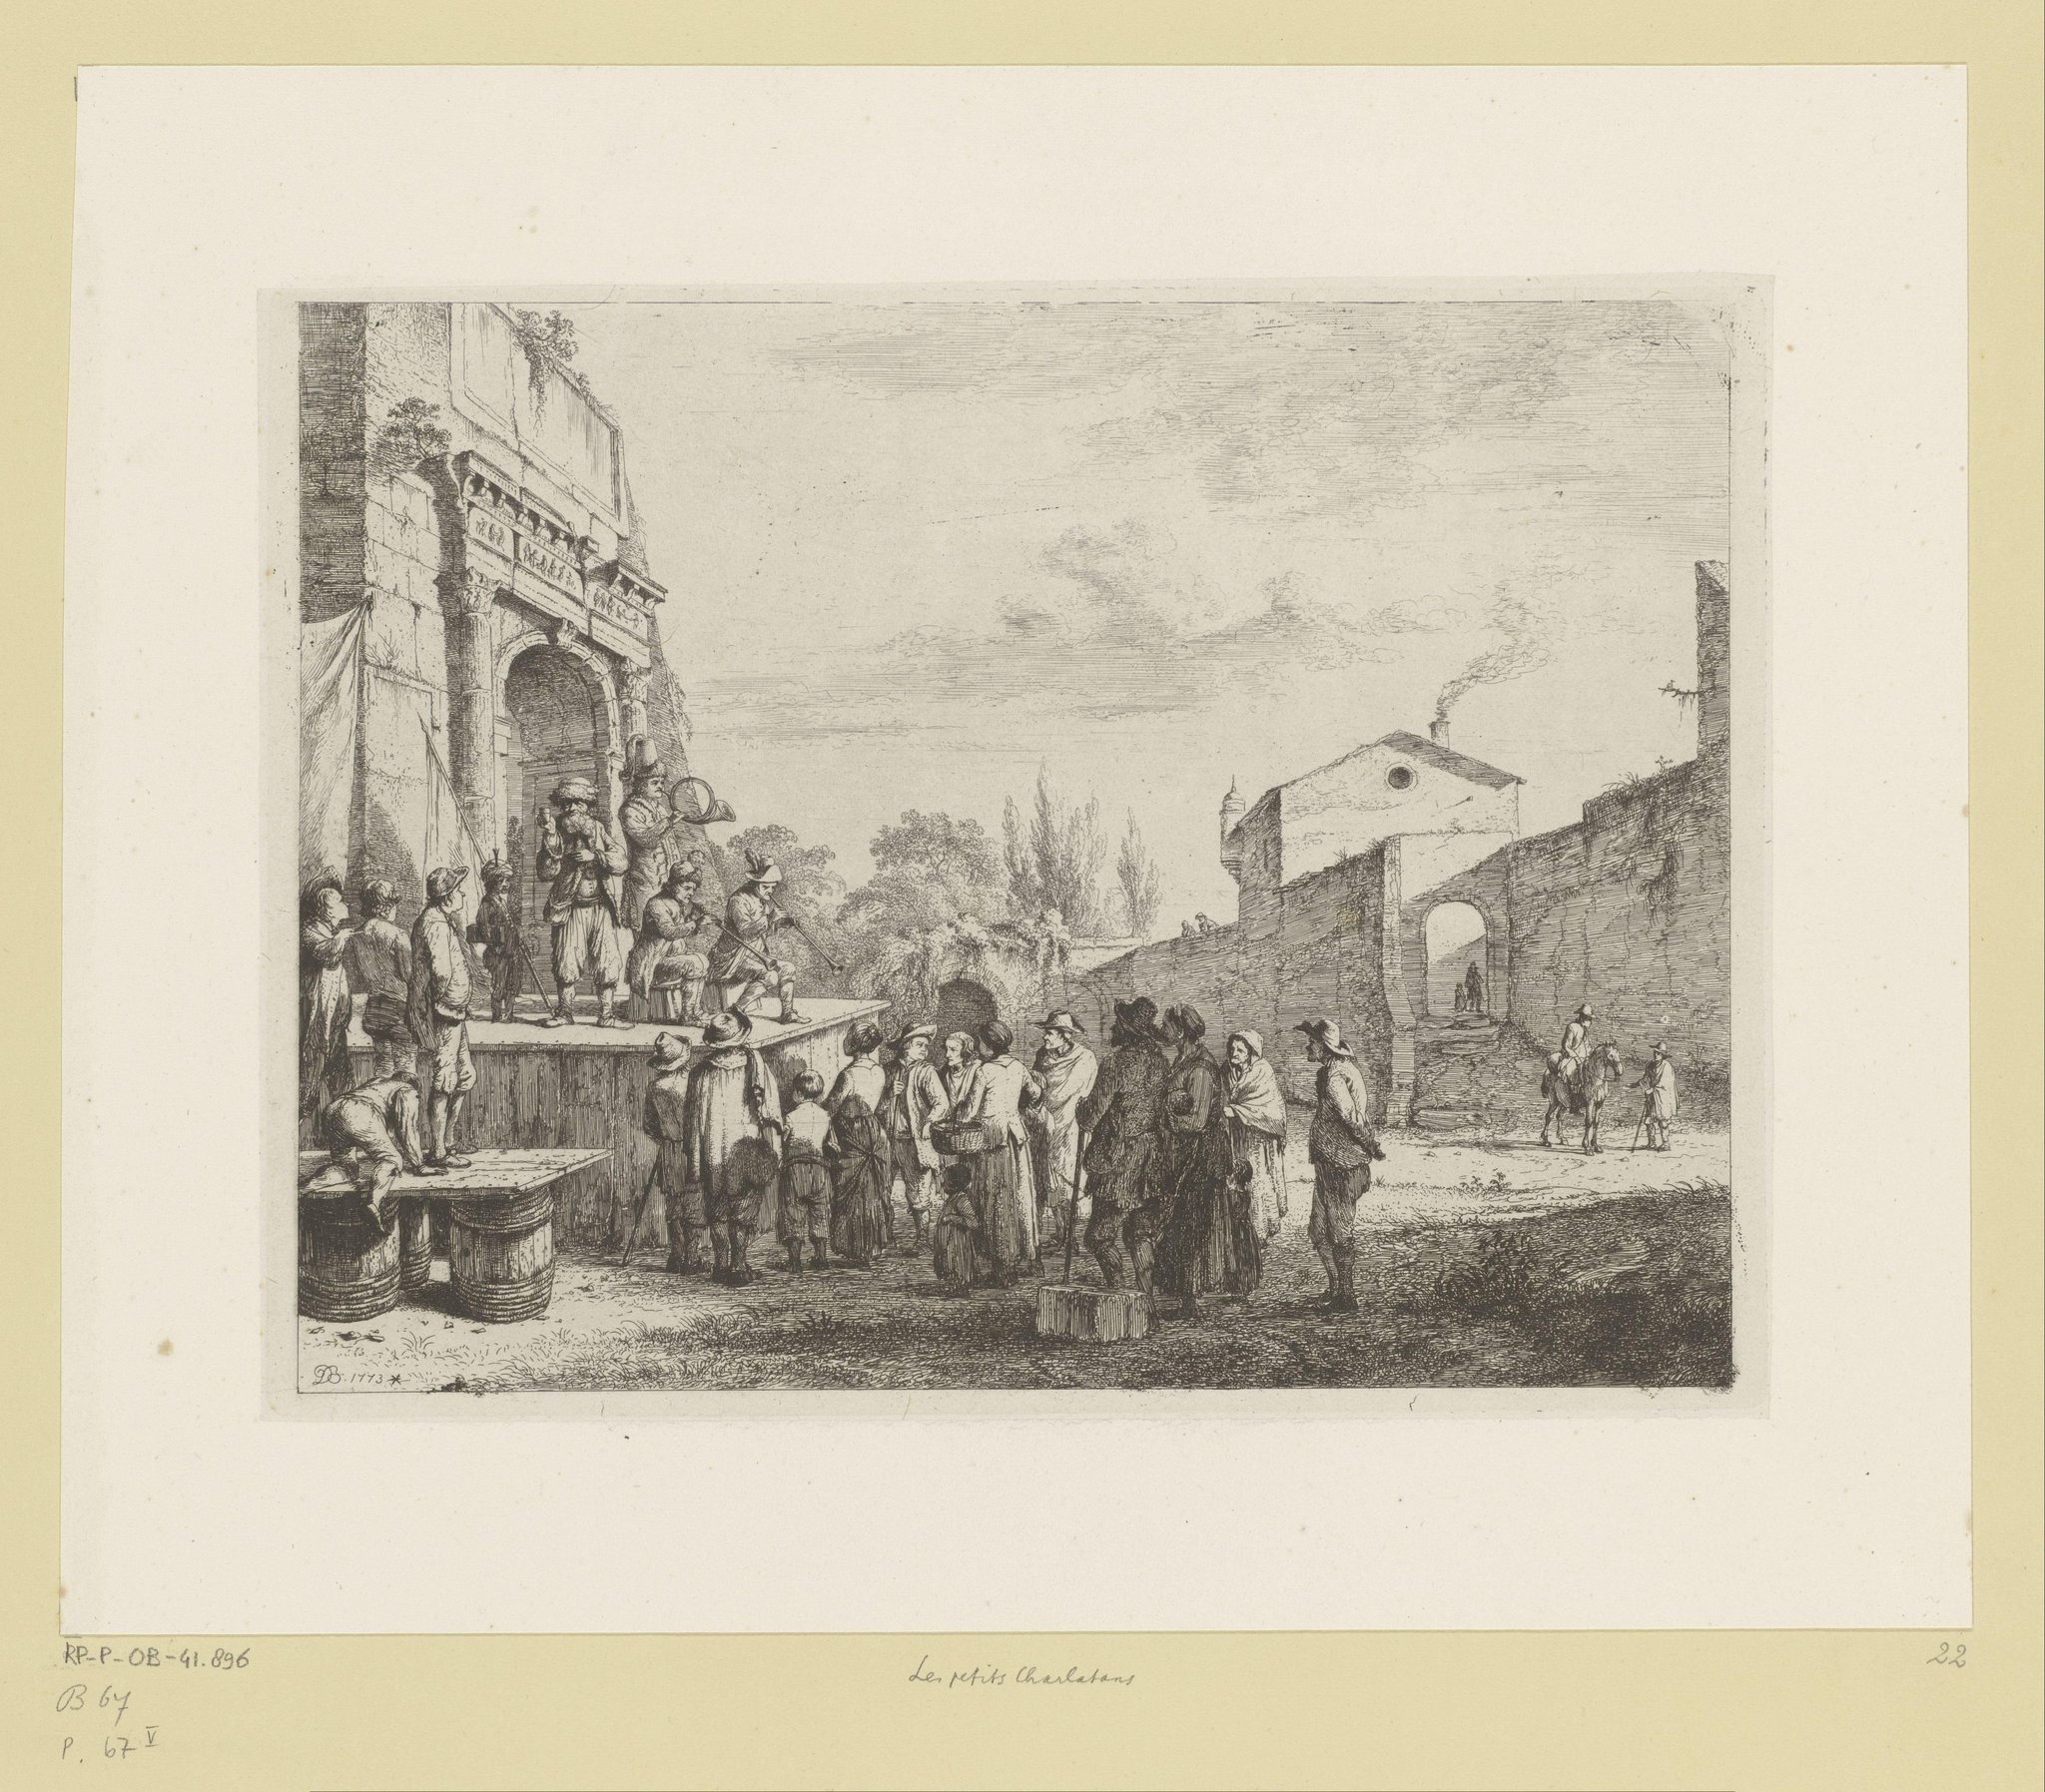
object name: print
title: Landschap met charlatans op een toneel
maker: jean jacques de boissieu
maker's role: draughtsman, print maker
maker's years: 1736-1810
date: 1773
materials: paper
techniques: etching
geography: france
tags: quack, charlatan, mountebank, 'saltimbanco', performance in the open air (pleasure fair)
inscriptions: collector's mark: Lugt 12